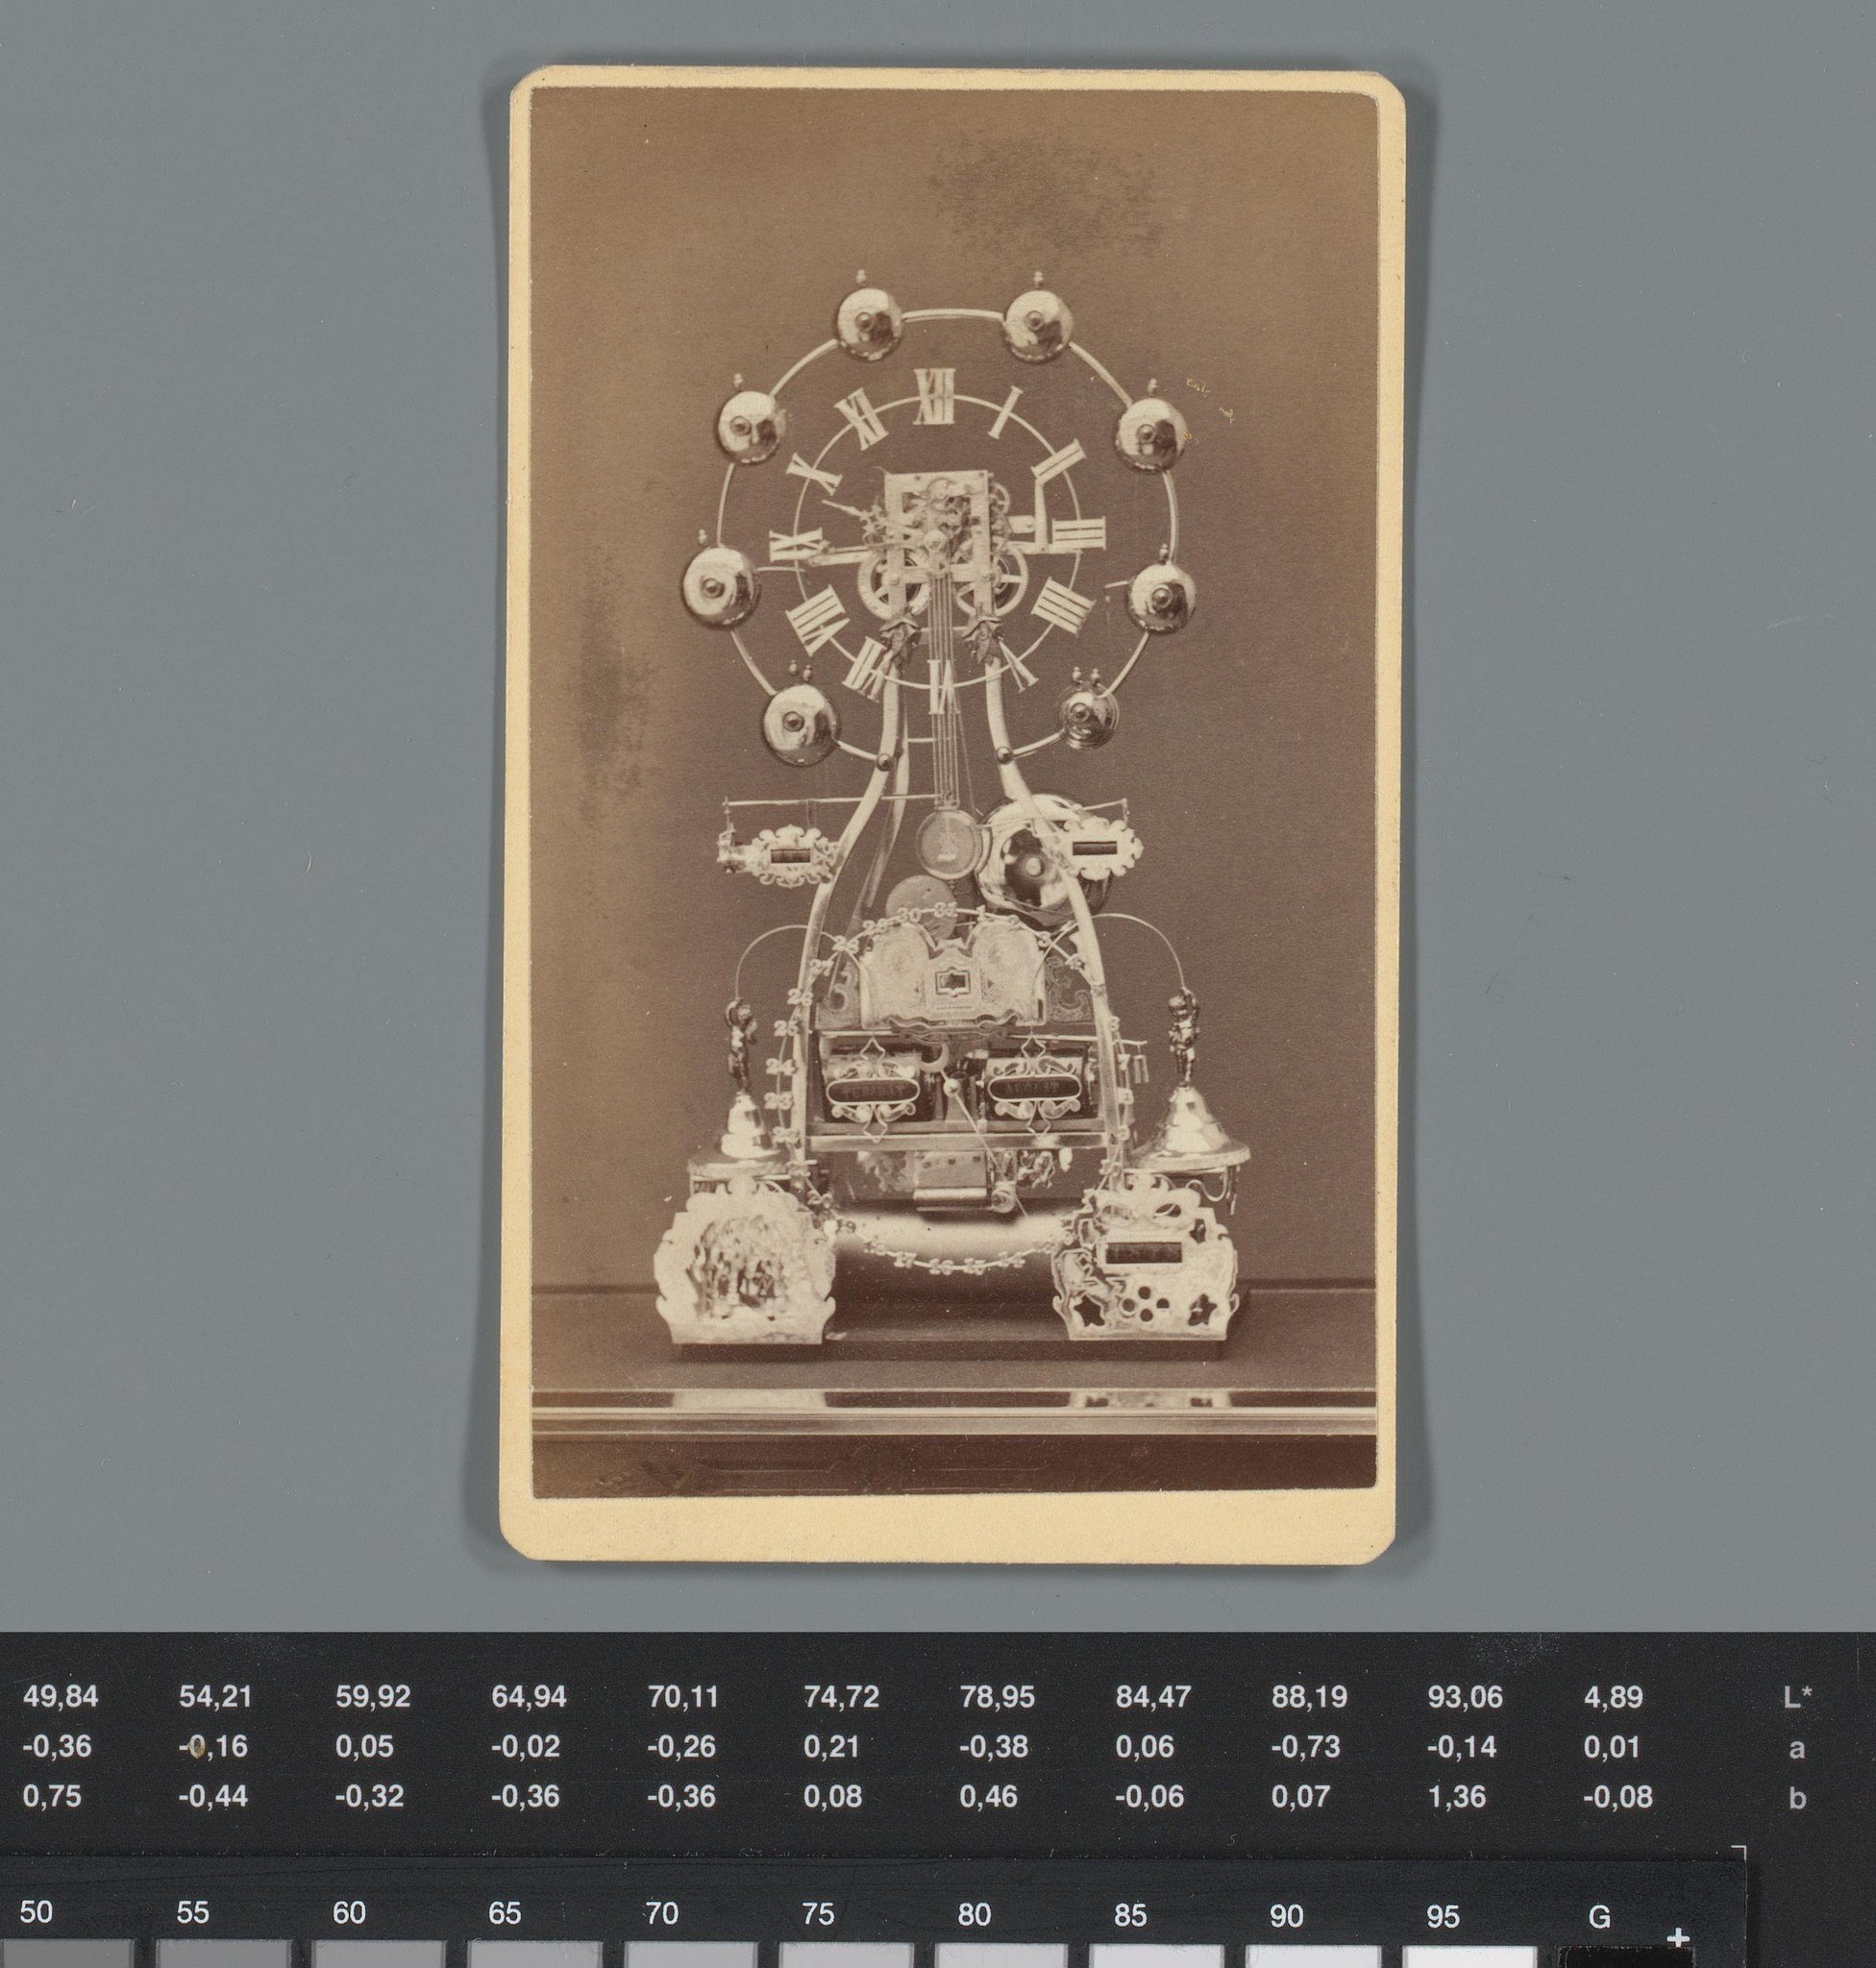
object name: carte de visite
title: Reclame voor juwelen van W.L. Bundy te Auburn met gezicht op een tafelklok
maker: Anonymous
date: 1850-1915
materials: cardboard, photographic support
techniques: albumen print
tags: advertising, clock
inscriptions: inscription: ‘W. L. BUNDY, / Manufacturing Jeweler, / Gold and Silver Plater. / 90 Genesee St., / AUBURN, N.Y.’